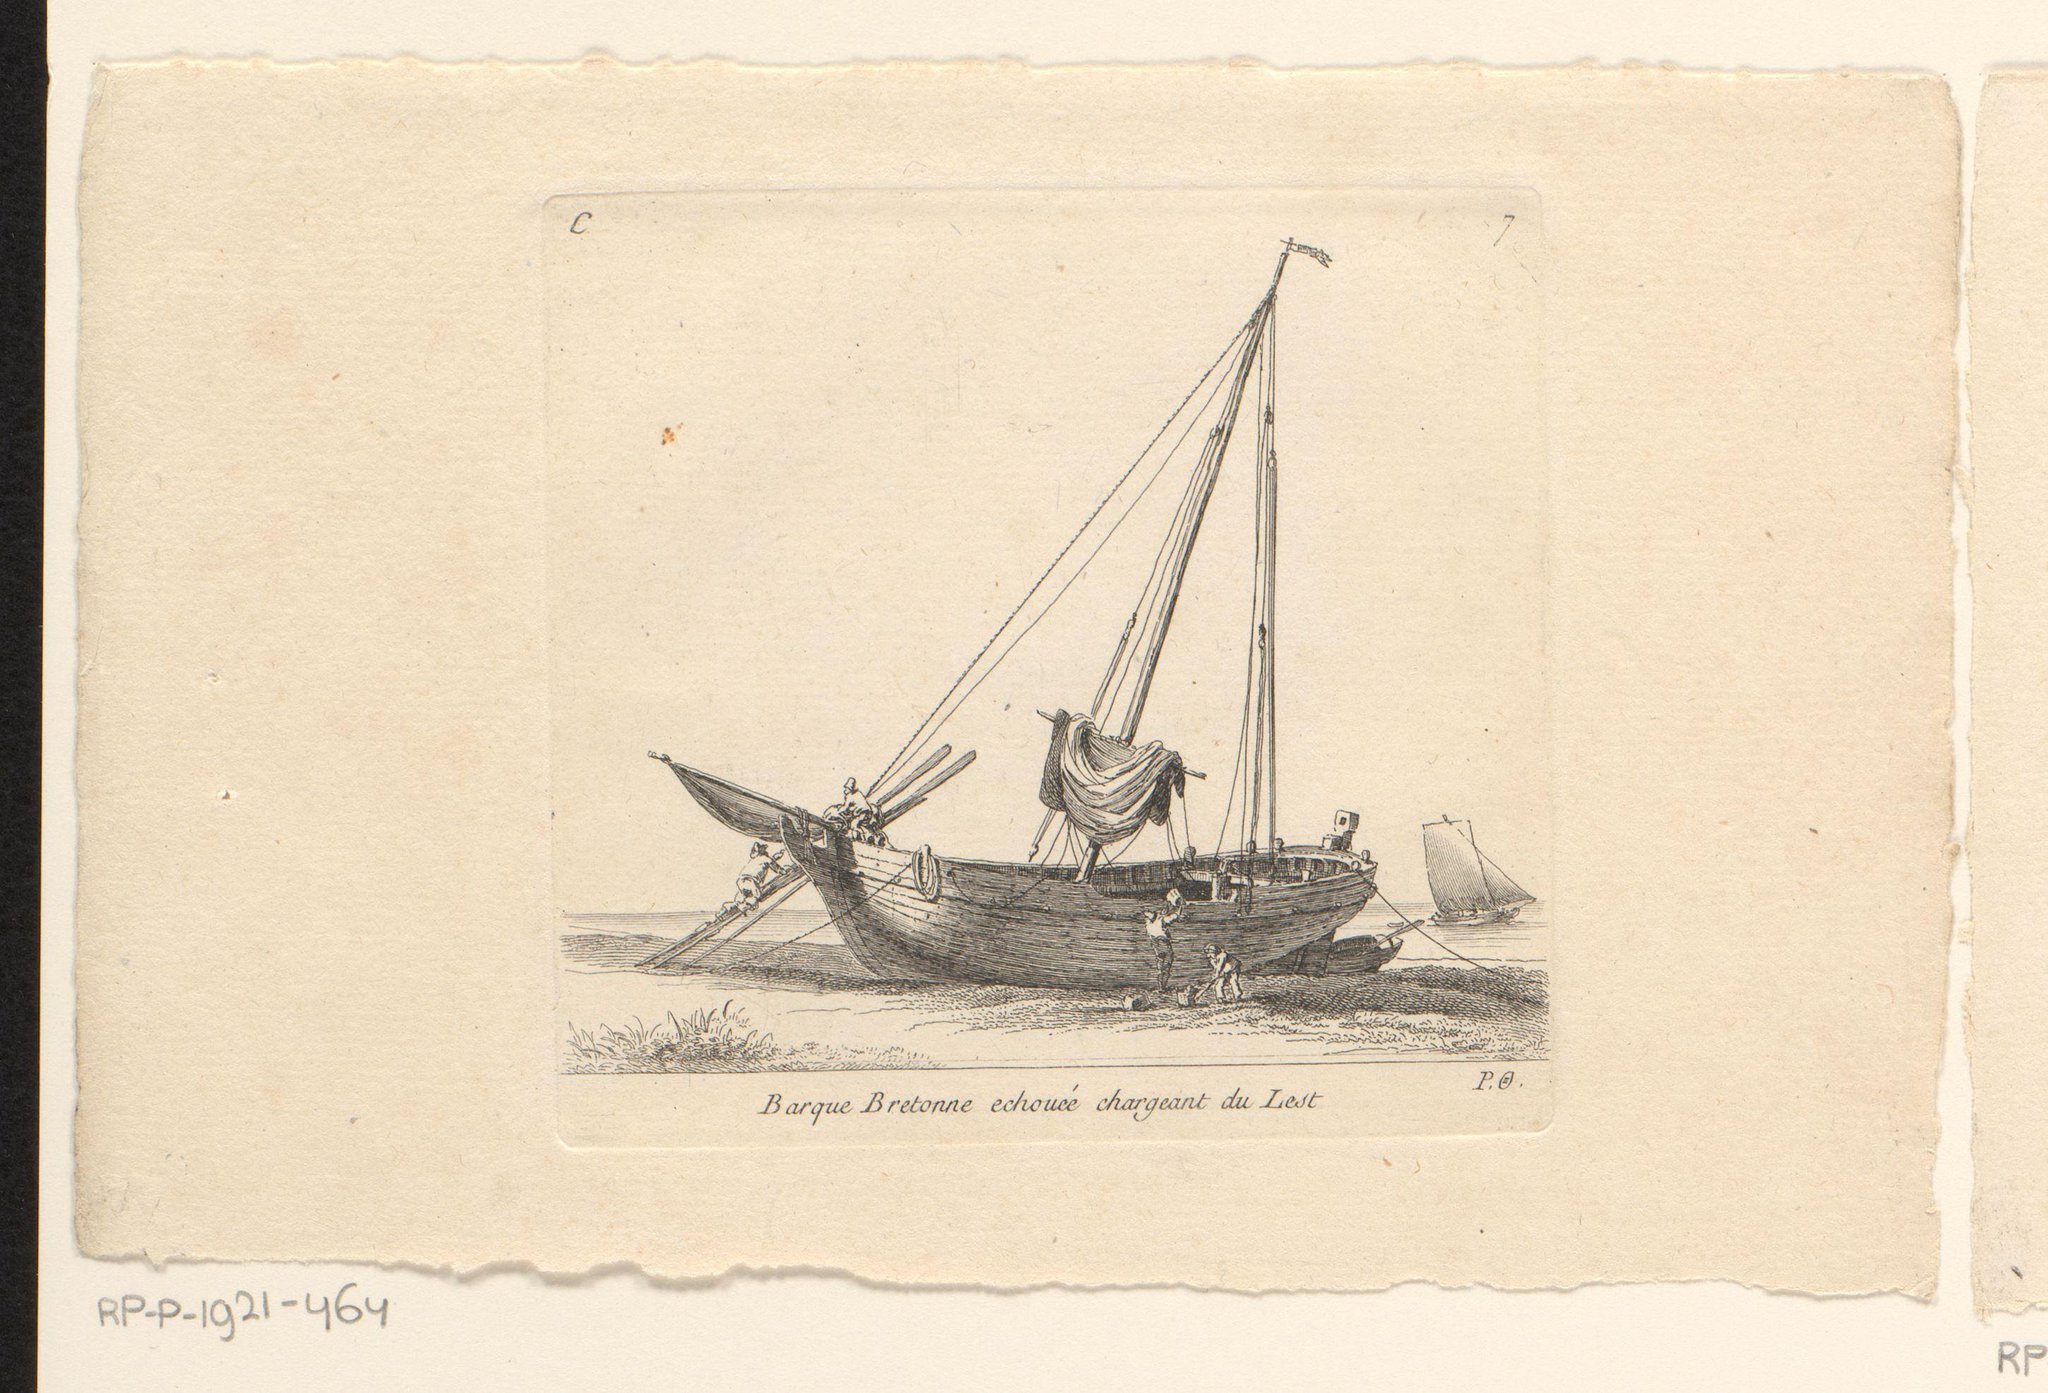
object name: print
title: Barque Bretonne echouée chargeant du Lest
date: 1747-1813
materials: paper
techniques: etching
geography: paris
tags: sailing-ship, sailing-boat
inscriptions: collector's mark: Lugt 2233